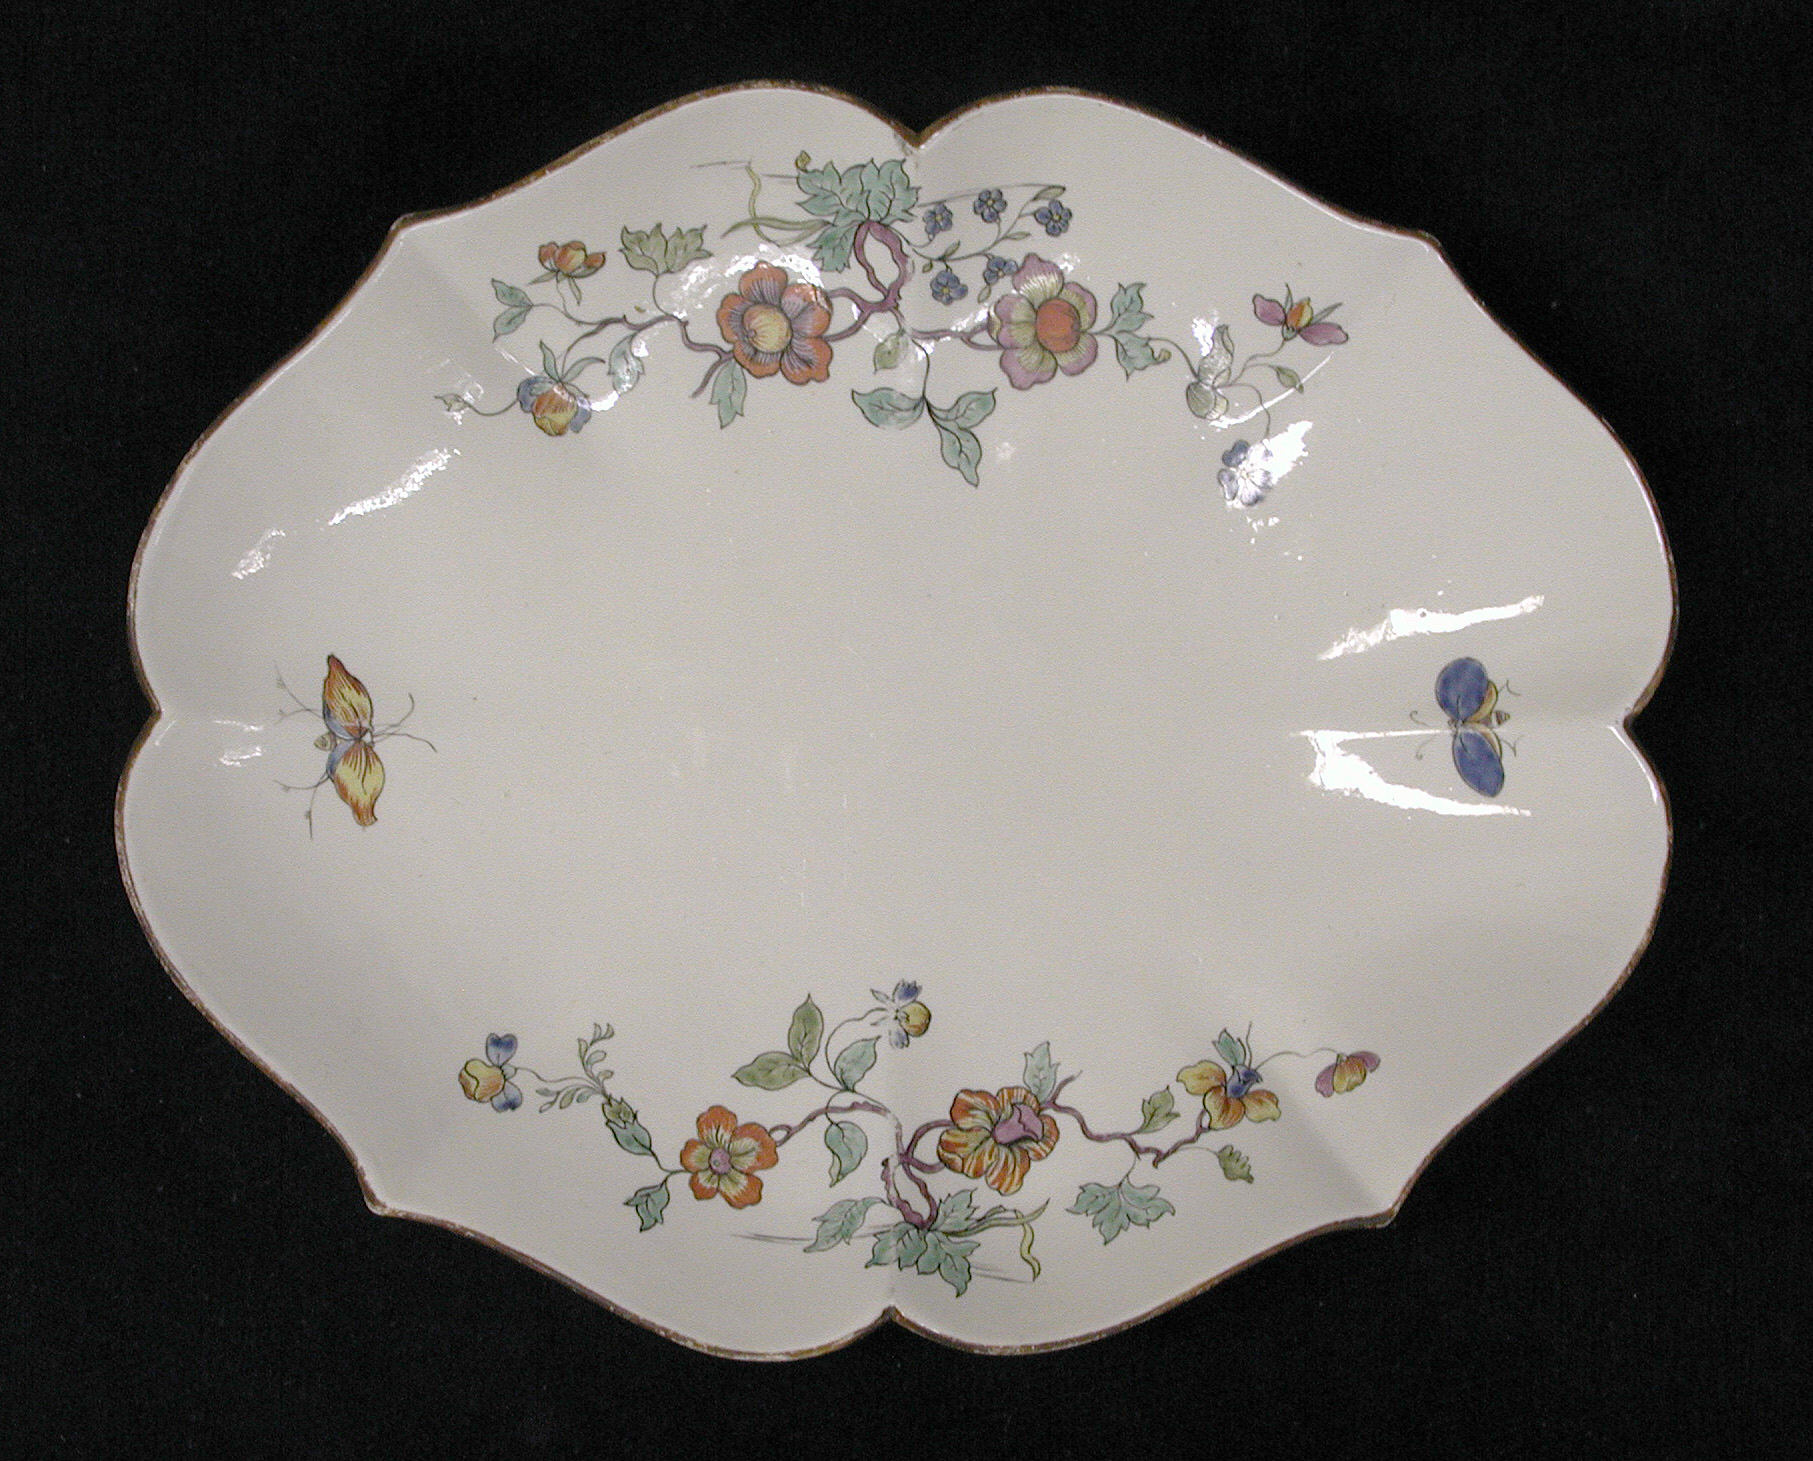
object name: tray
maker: chantilly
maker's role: factory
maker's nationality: french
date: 1740-1745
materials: soft paste porcelain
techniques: glazing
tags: butterflies,flowers